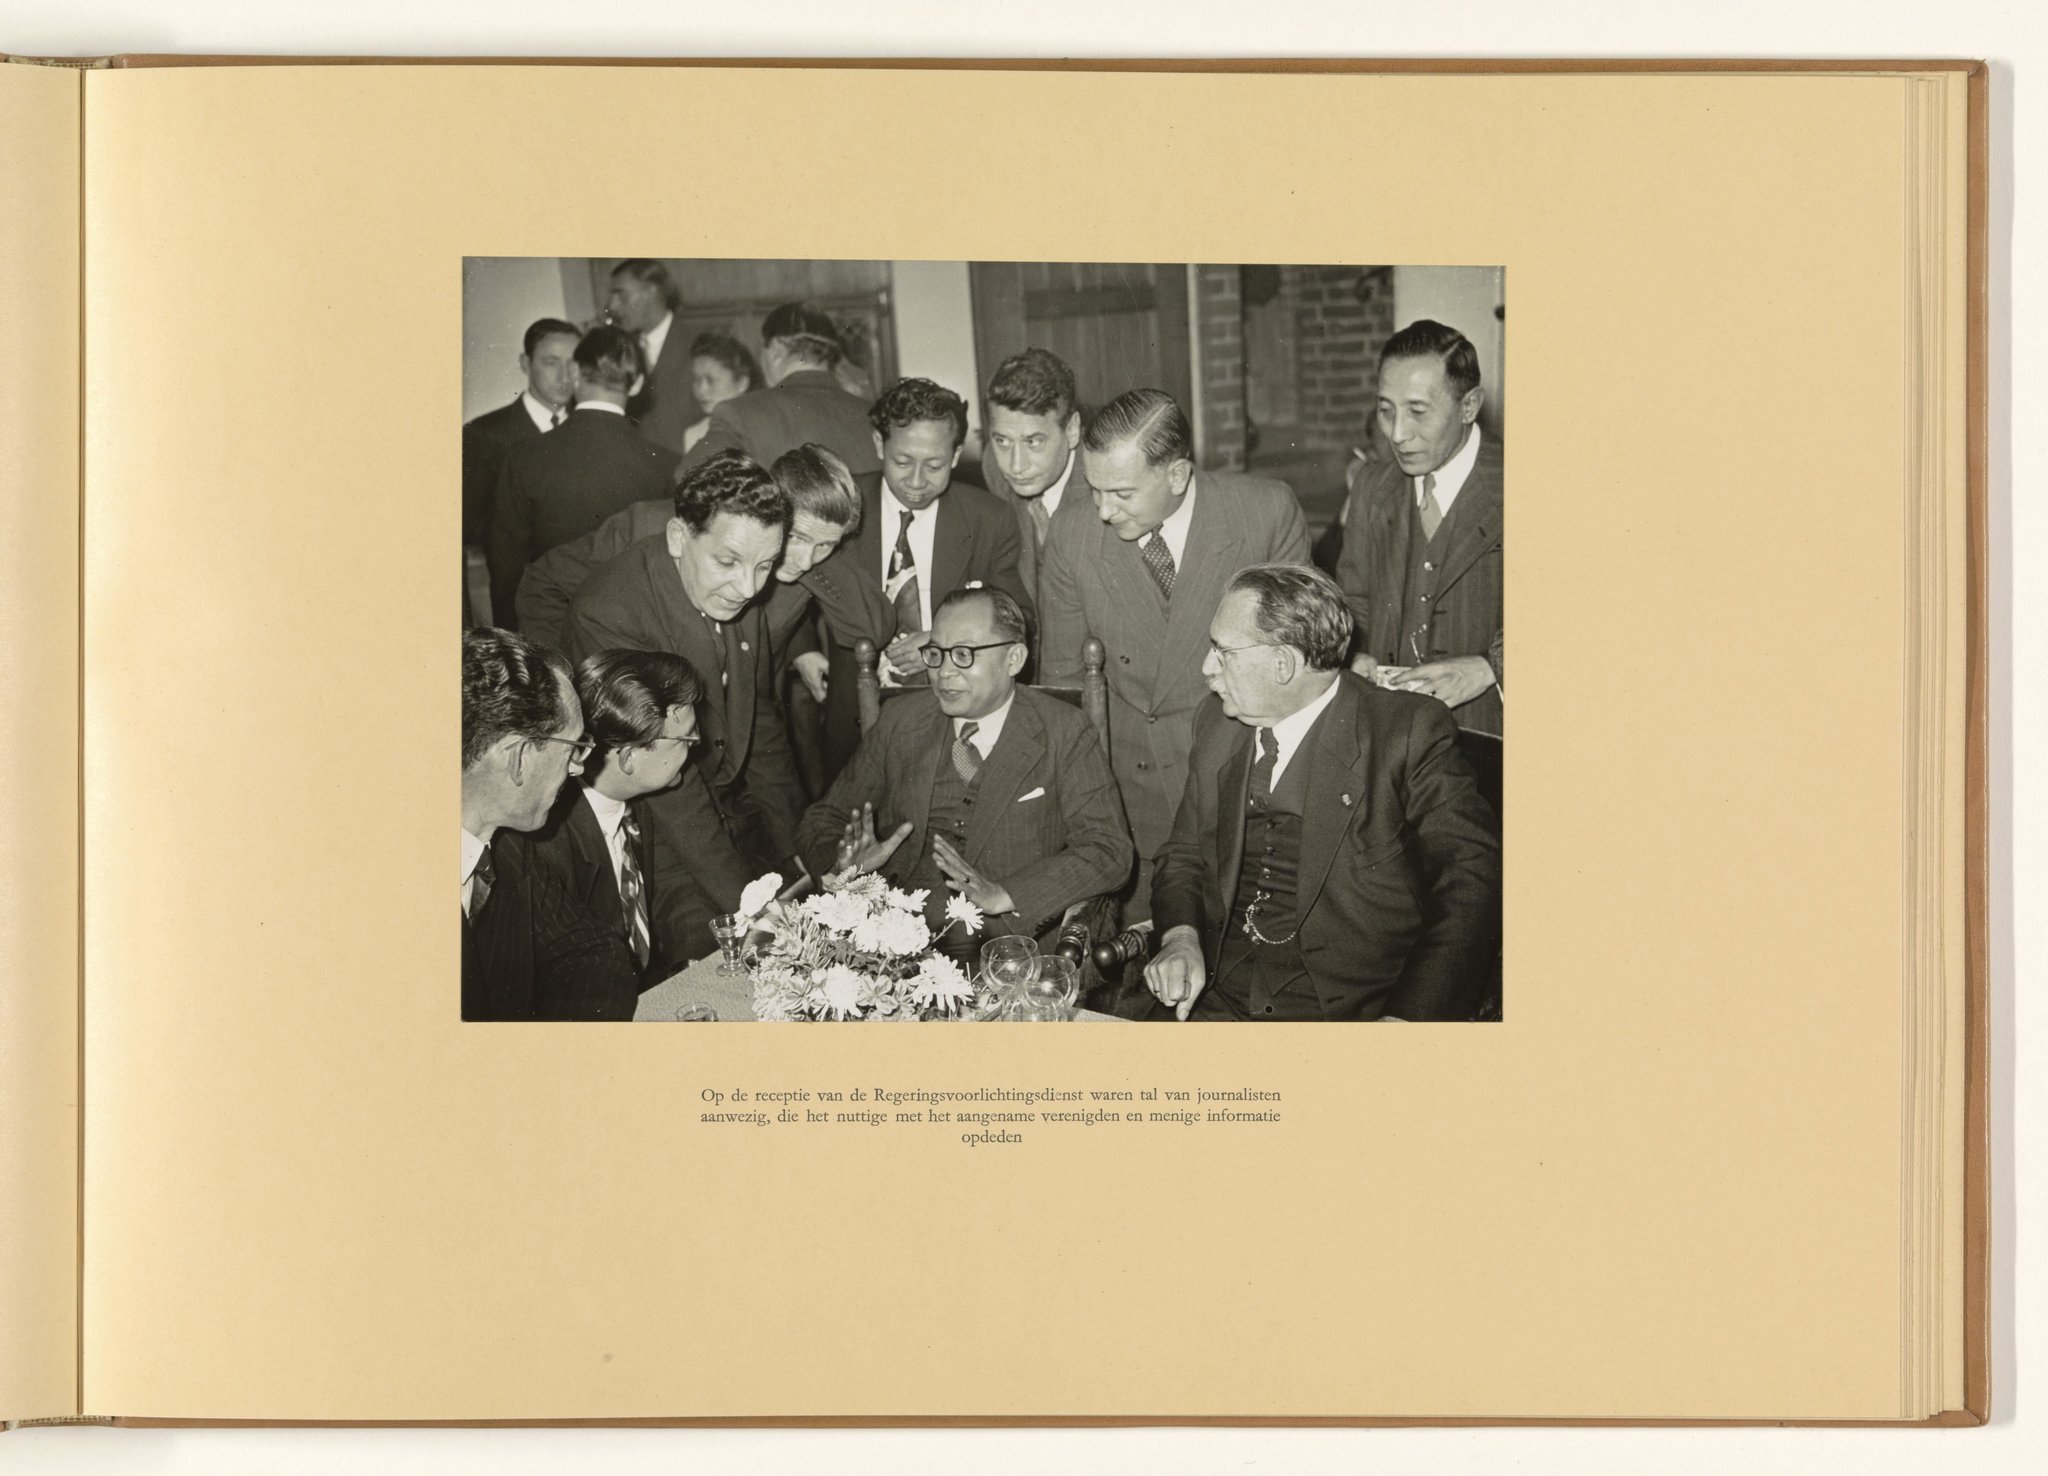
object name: photograph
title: Op de receptie van de Regeringsvoorlichtingsdienst waren tal van journalisten aanwezig, die het nuttige met het aangename verenigden en menige informatie opdeden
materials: paper, photographic support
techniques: gelatin silver print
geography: the hague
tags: mohammad hatta, amsterdam, willem drees, the hague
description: Premiers Hatta en Drees tussen journalisten op de receptie van de Regeringsvoorlichtingsdienst. Foto in het fotoalbum met 37 foto's van de rondetafelconferentie gehouden tussen 23 augustus en 2 november in Den Haag in 1949 tussen vertegenwoordigers van Nederland, de Republiek Indonesië en de Bijeenkomst Federaal Overleg. Het exemplaar aangeboden aan premier Willem Drees.